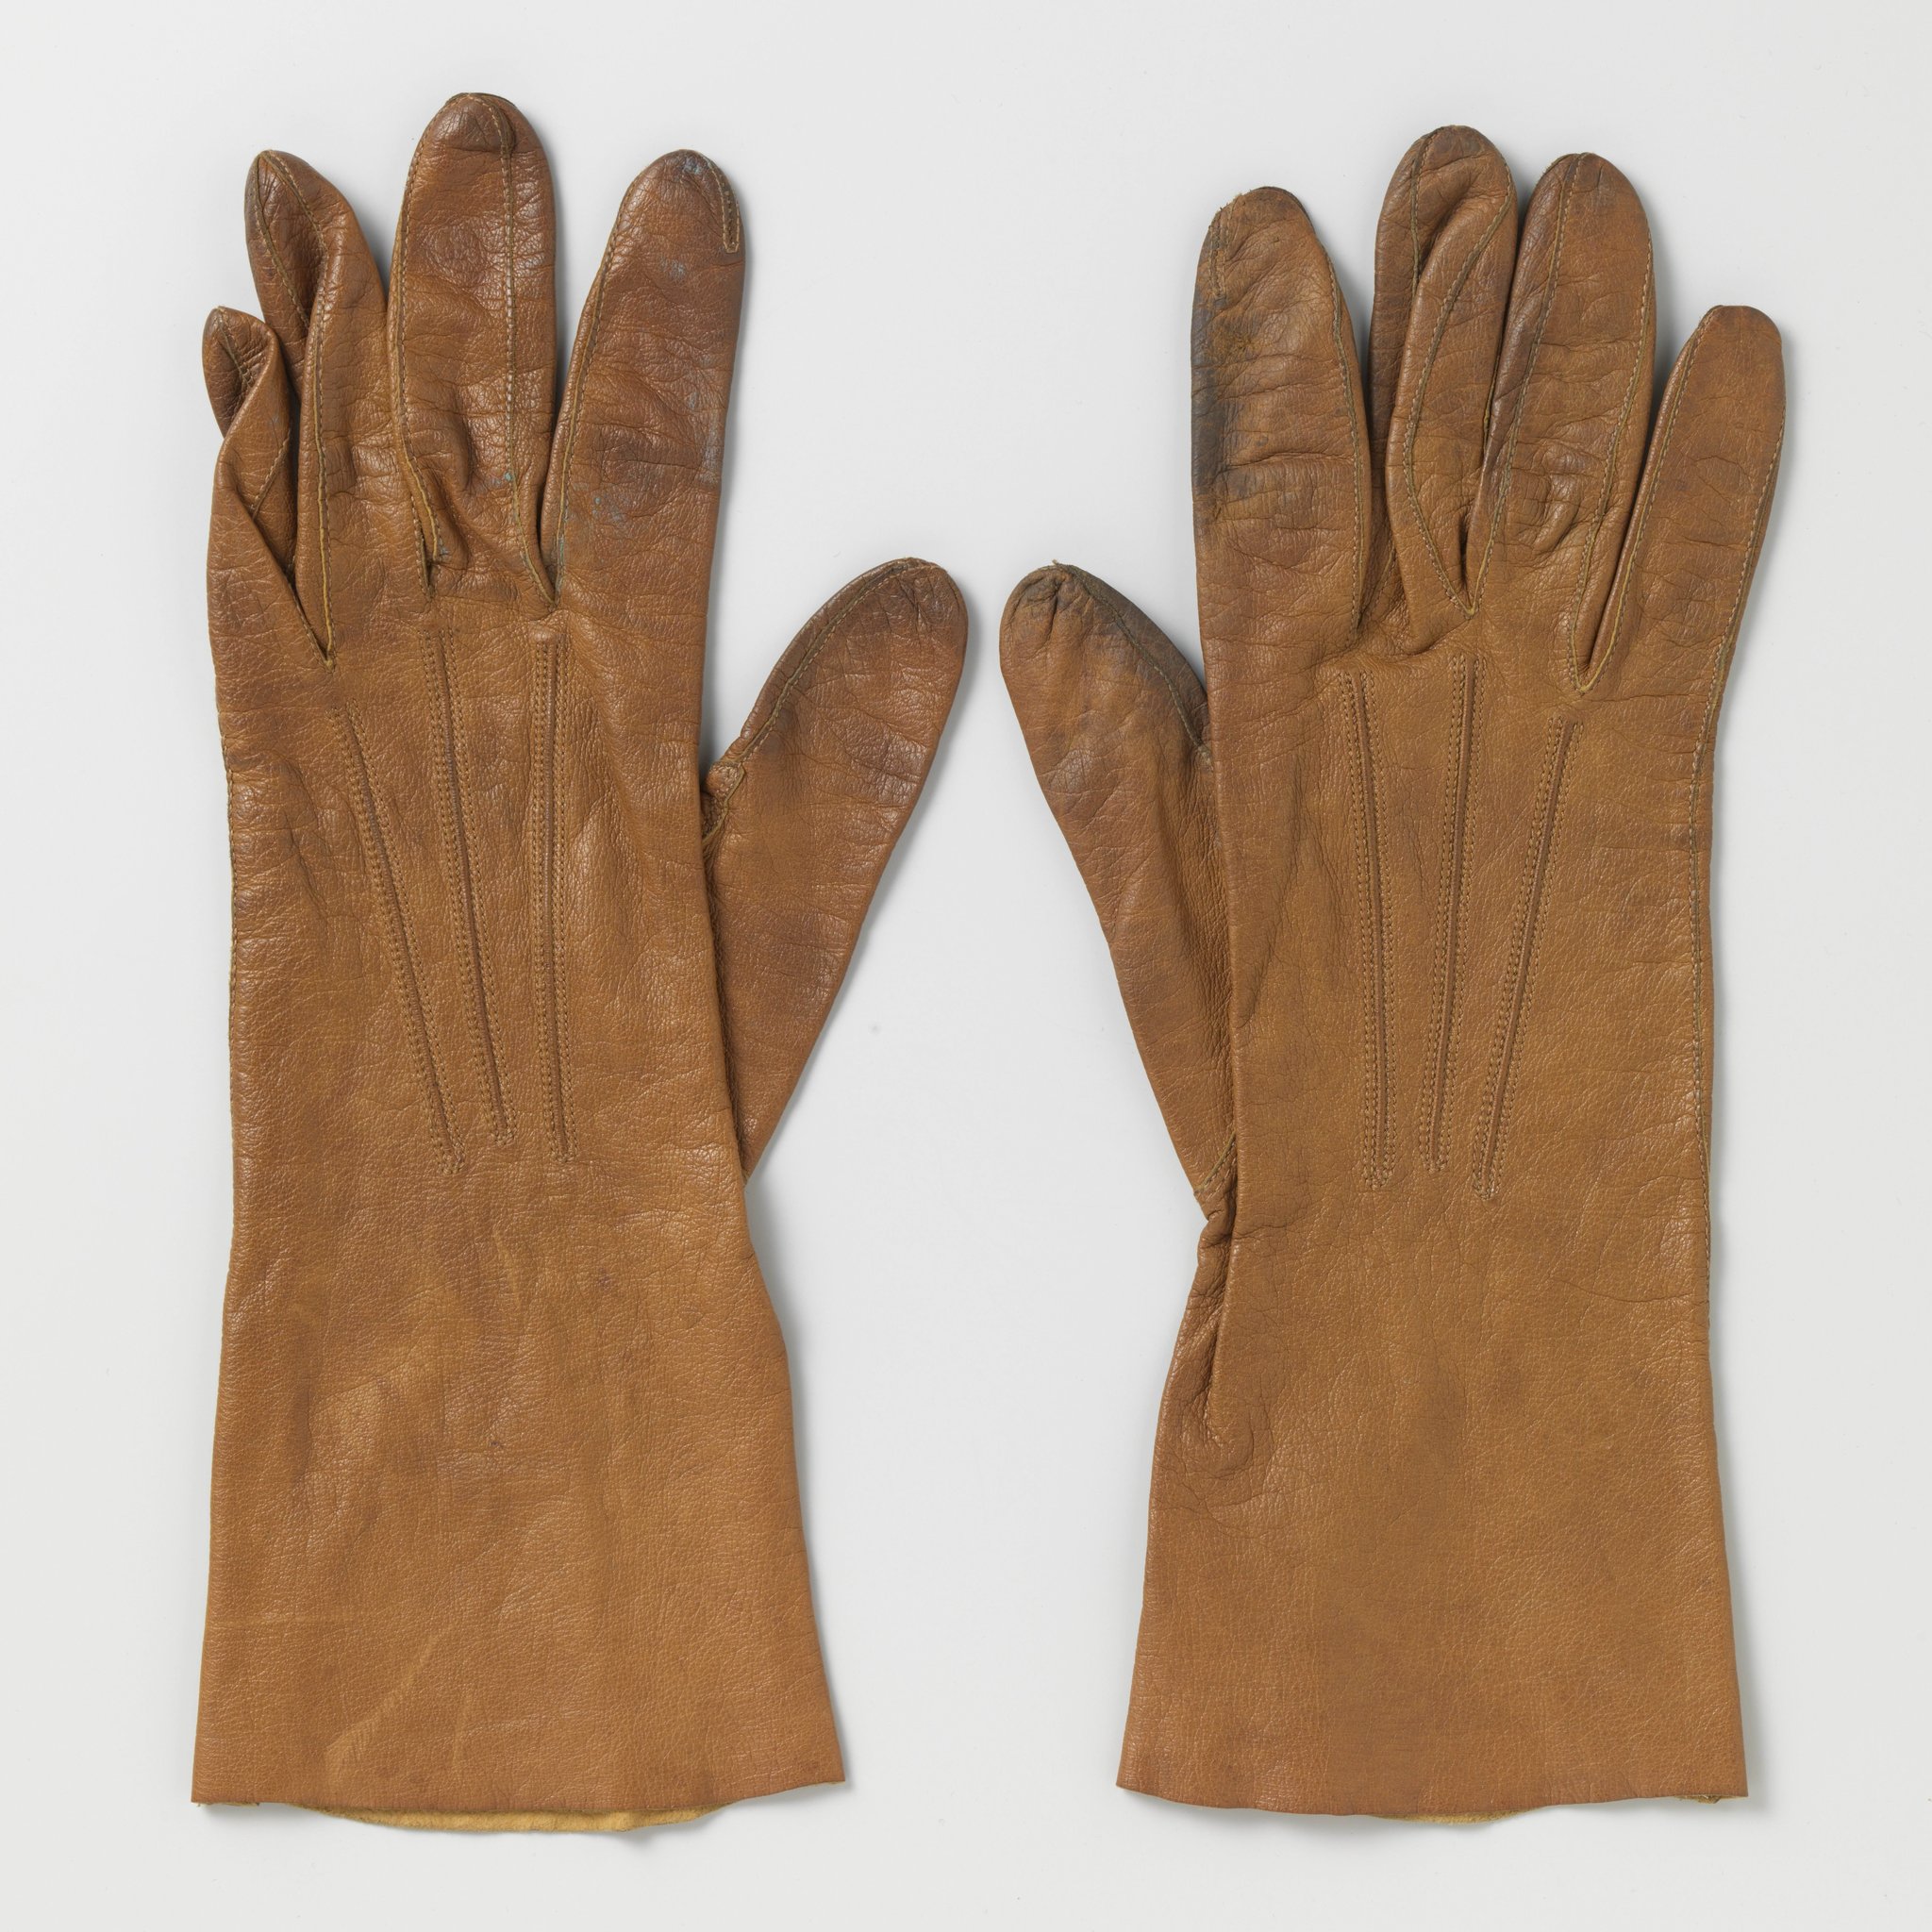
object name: glove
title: Pair of gloves with radiating cords on the back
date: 1900-1915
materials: leather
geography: netherlands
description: Linkerhandschoen van bruin leer, met op de rug drie uitstralende koorden.